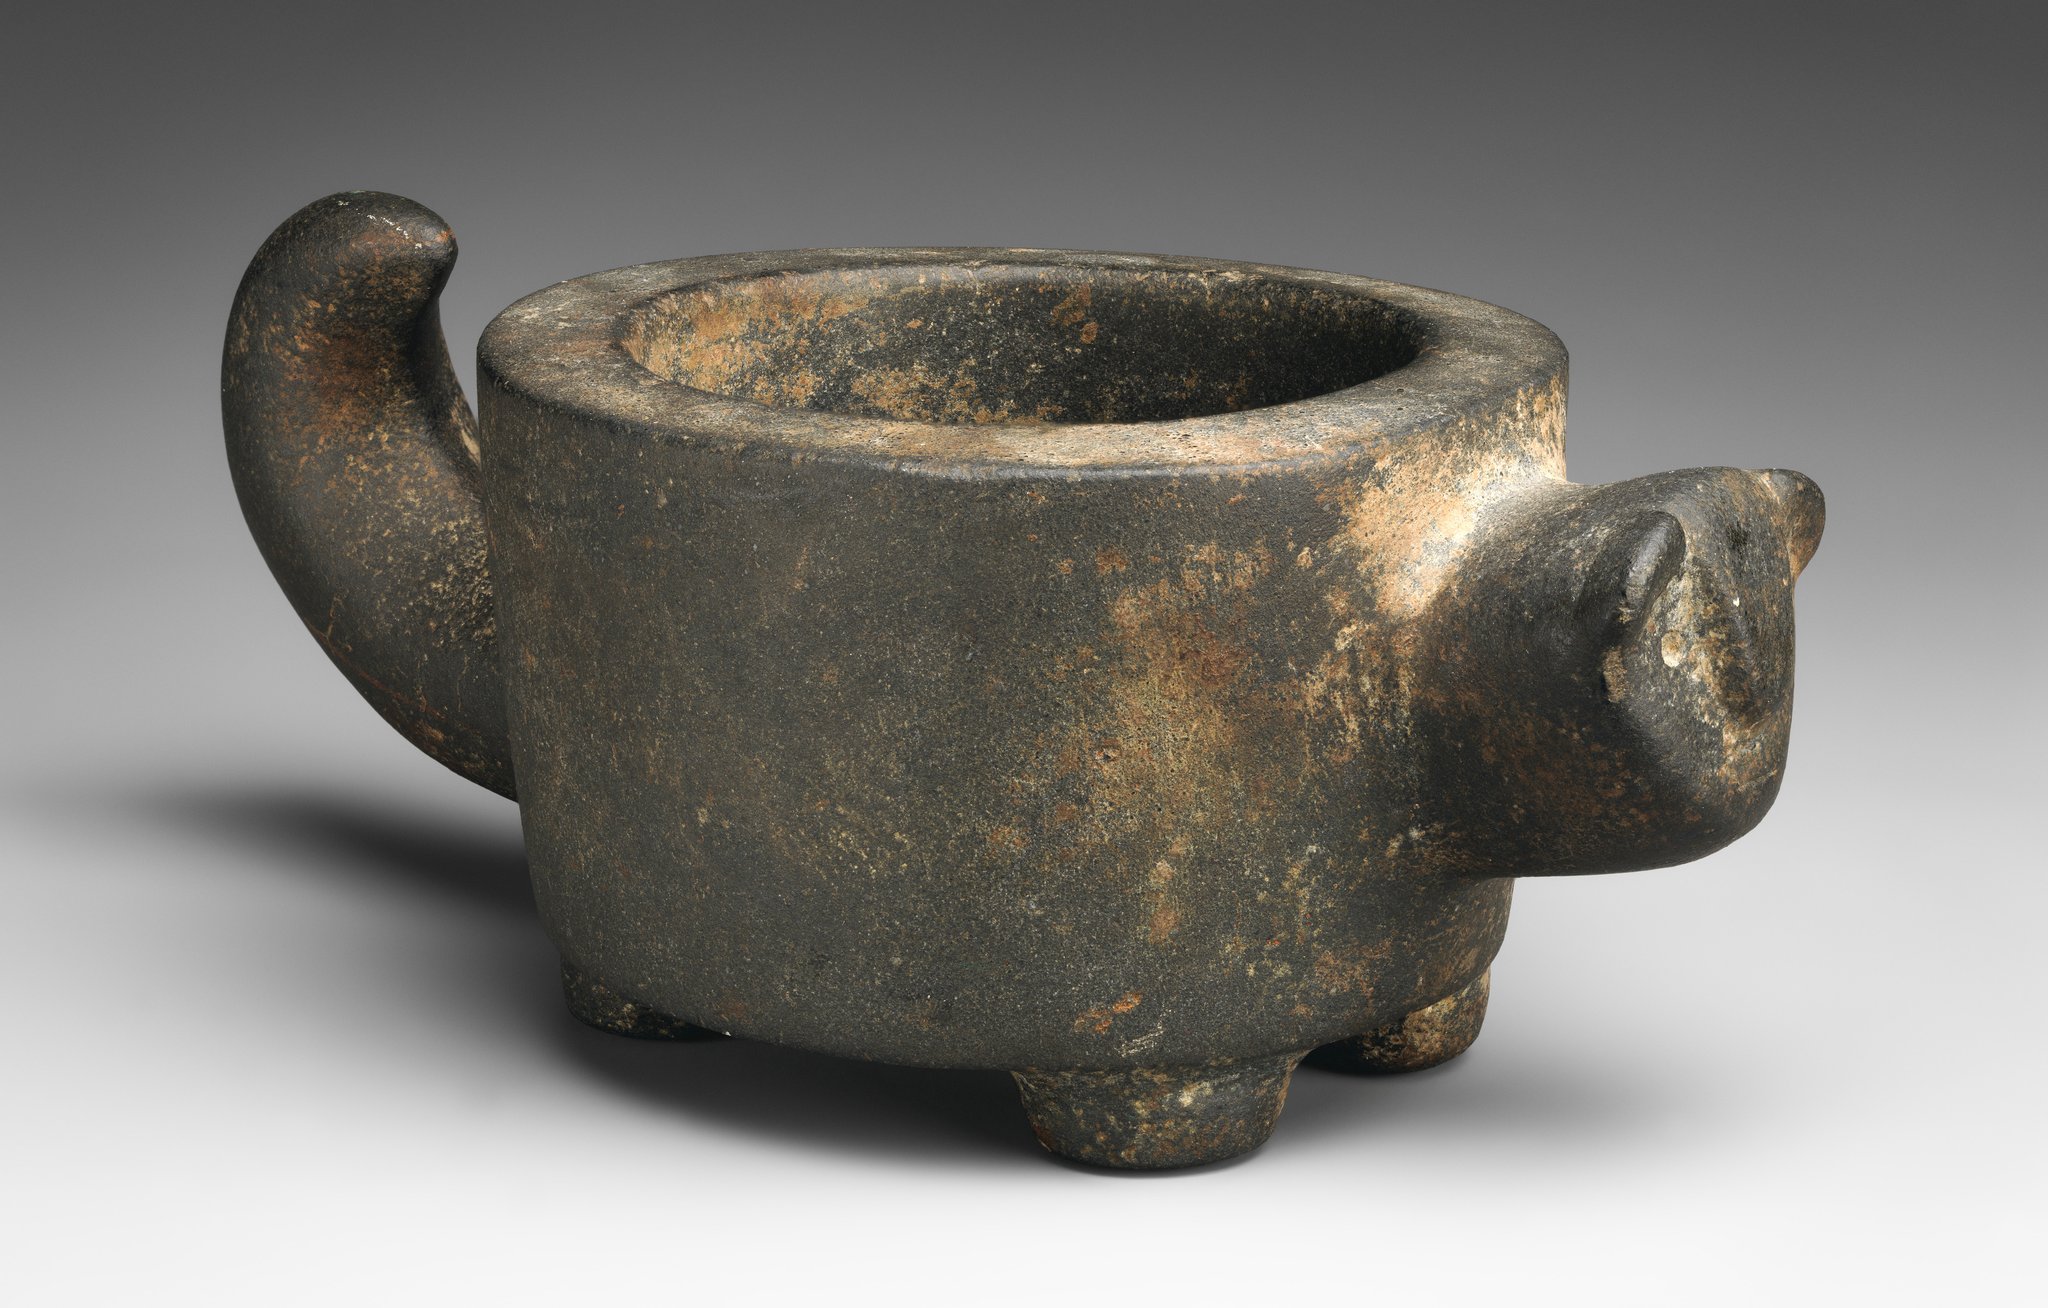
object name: bowl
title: Feline Bowl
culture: inca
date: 1301-1533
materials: stone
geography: peru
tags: cats